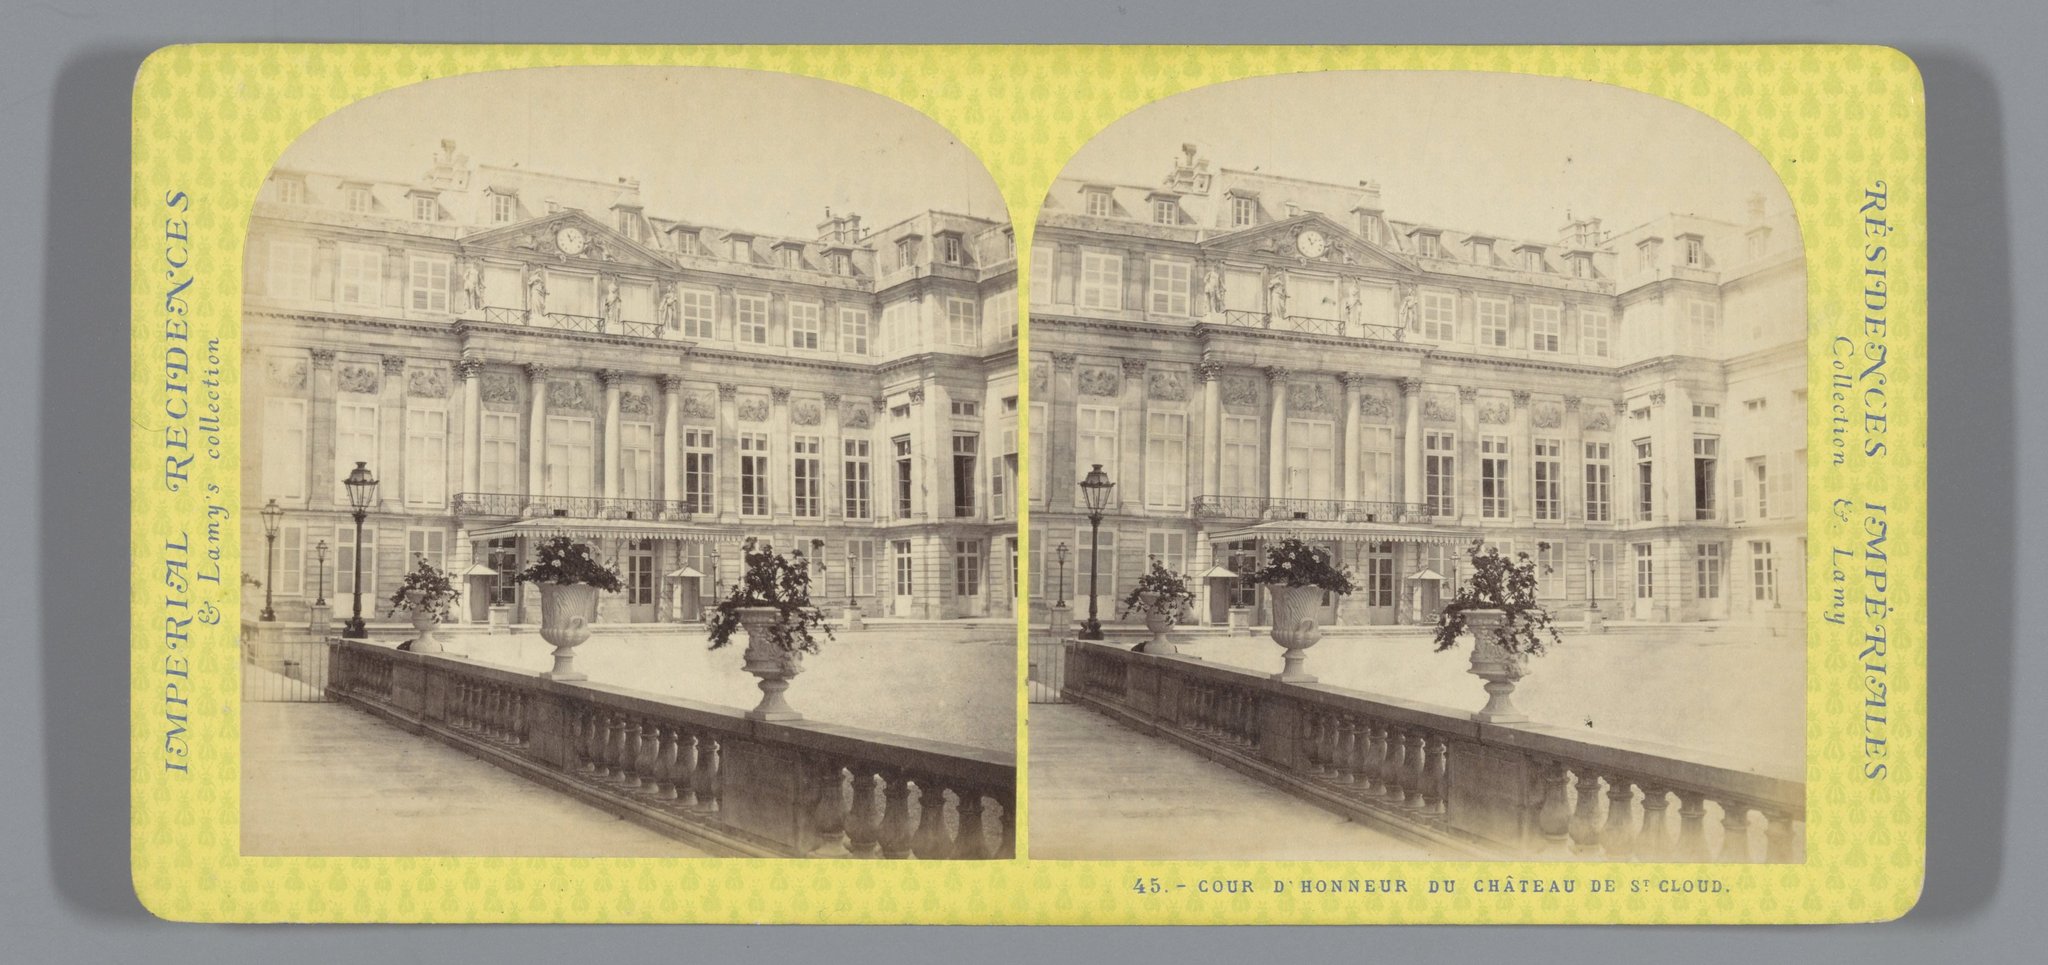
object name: stereograph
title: Binnenhof van het kasteel van Saint-Cloud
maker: ernest eléonor pierre lamy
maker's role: publisher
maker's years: 1828-1900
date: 1860-1870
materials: cardboard, photographic support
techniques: albumen print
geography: saint-cloud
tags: castle, façade (of house or building)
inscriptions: number: ‘E. Lamy's collection’, inscription: ‘E. Lamy's collection’